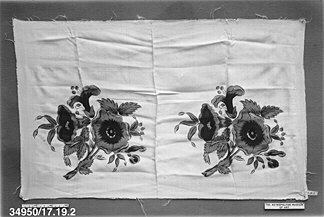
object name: silk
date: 1801-1900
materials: cotton